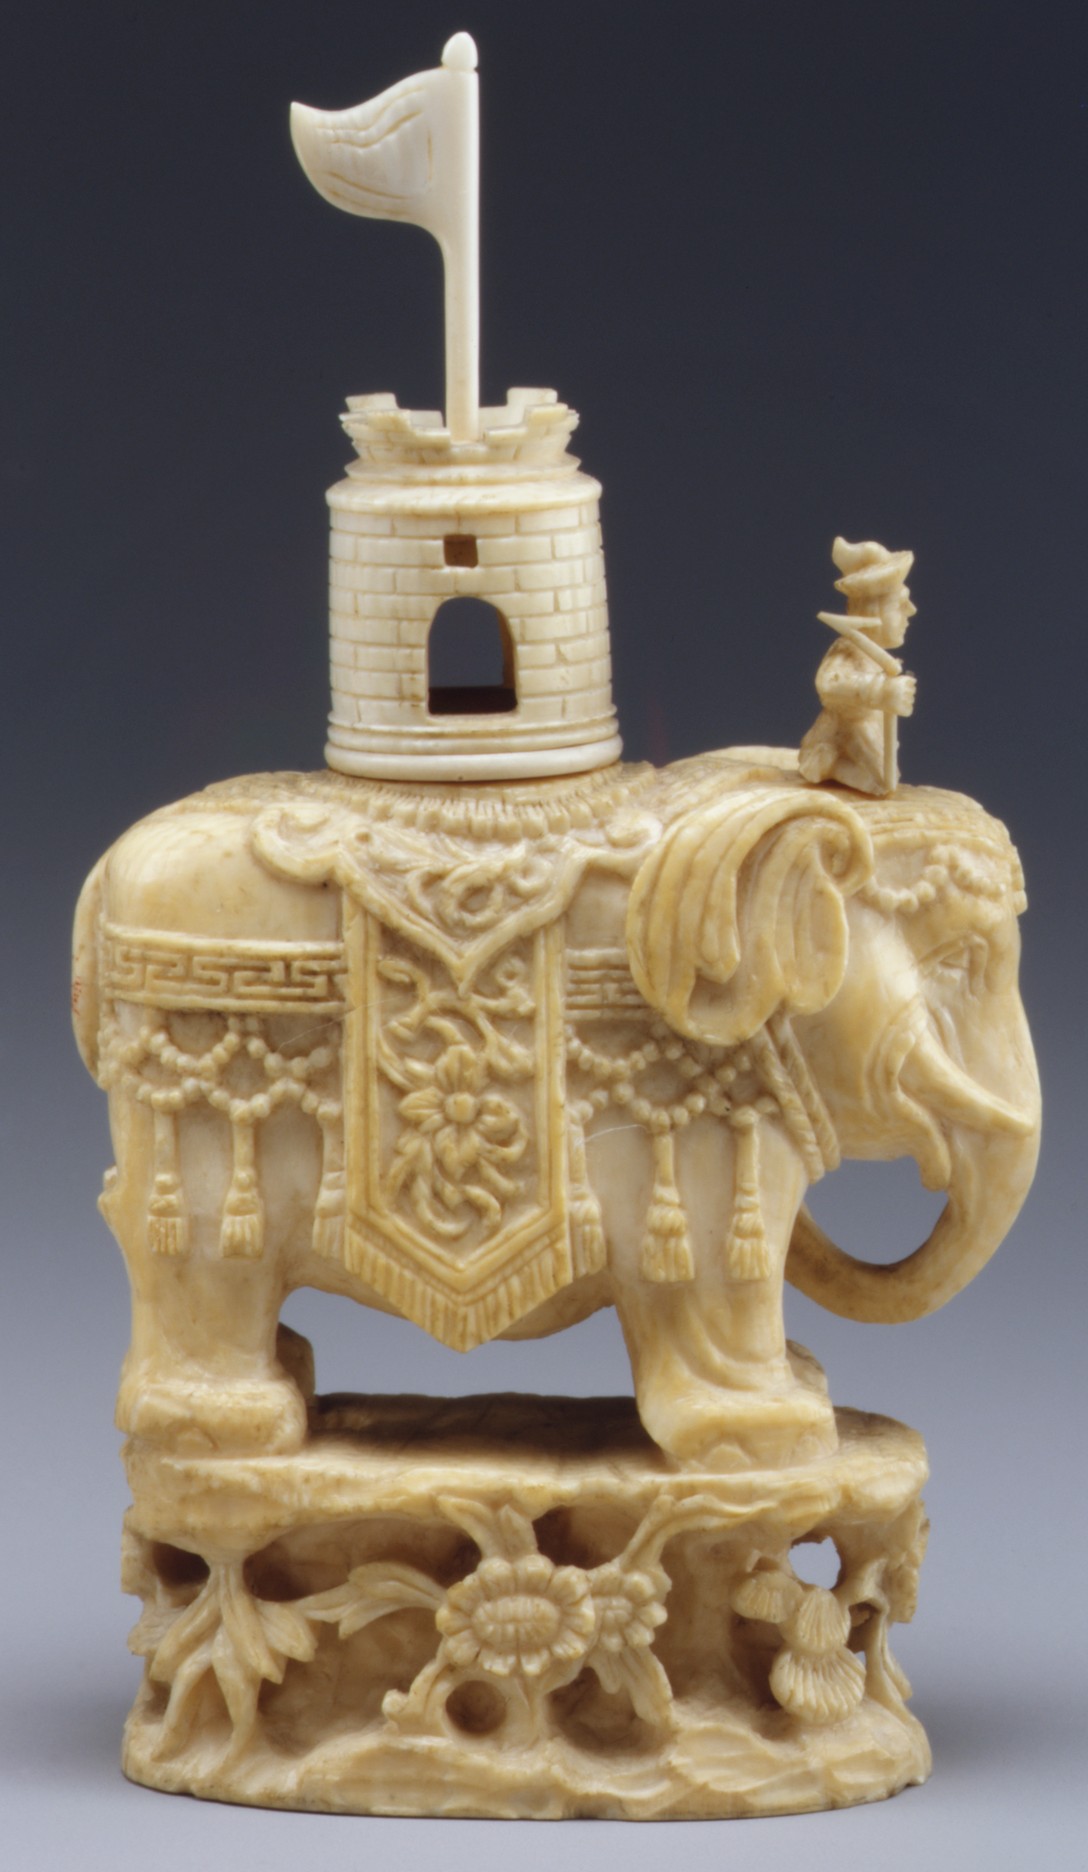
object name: chessman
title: Chessmen (32)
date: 1801-1900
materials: ivory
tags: men,chess,elephants,games